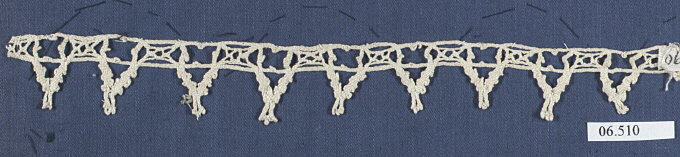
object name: fragment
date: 1567-1600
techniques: lace